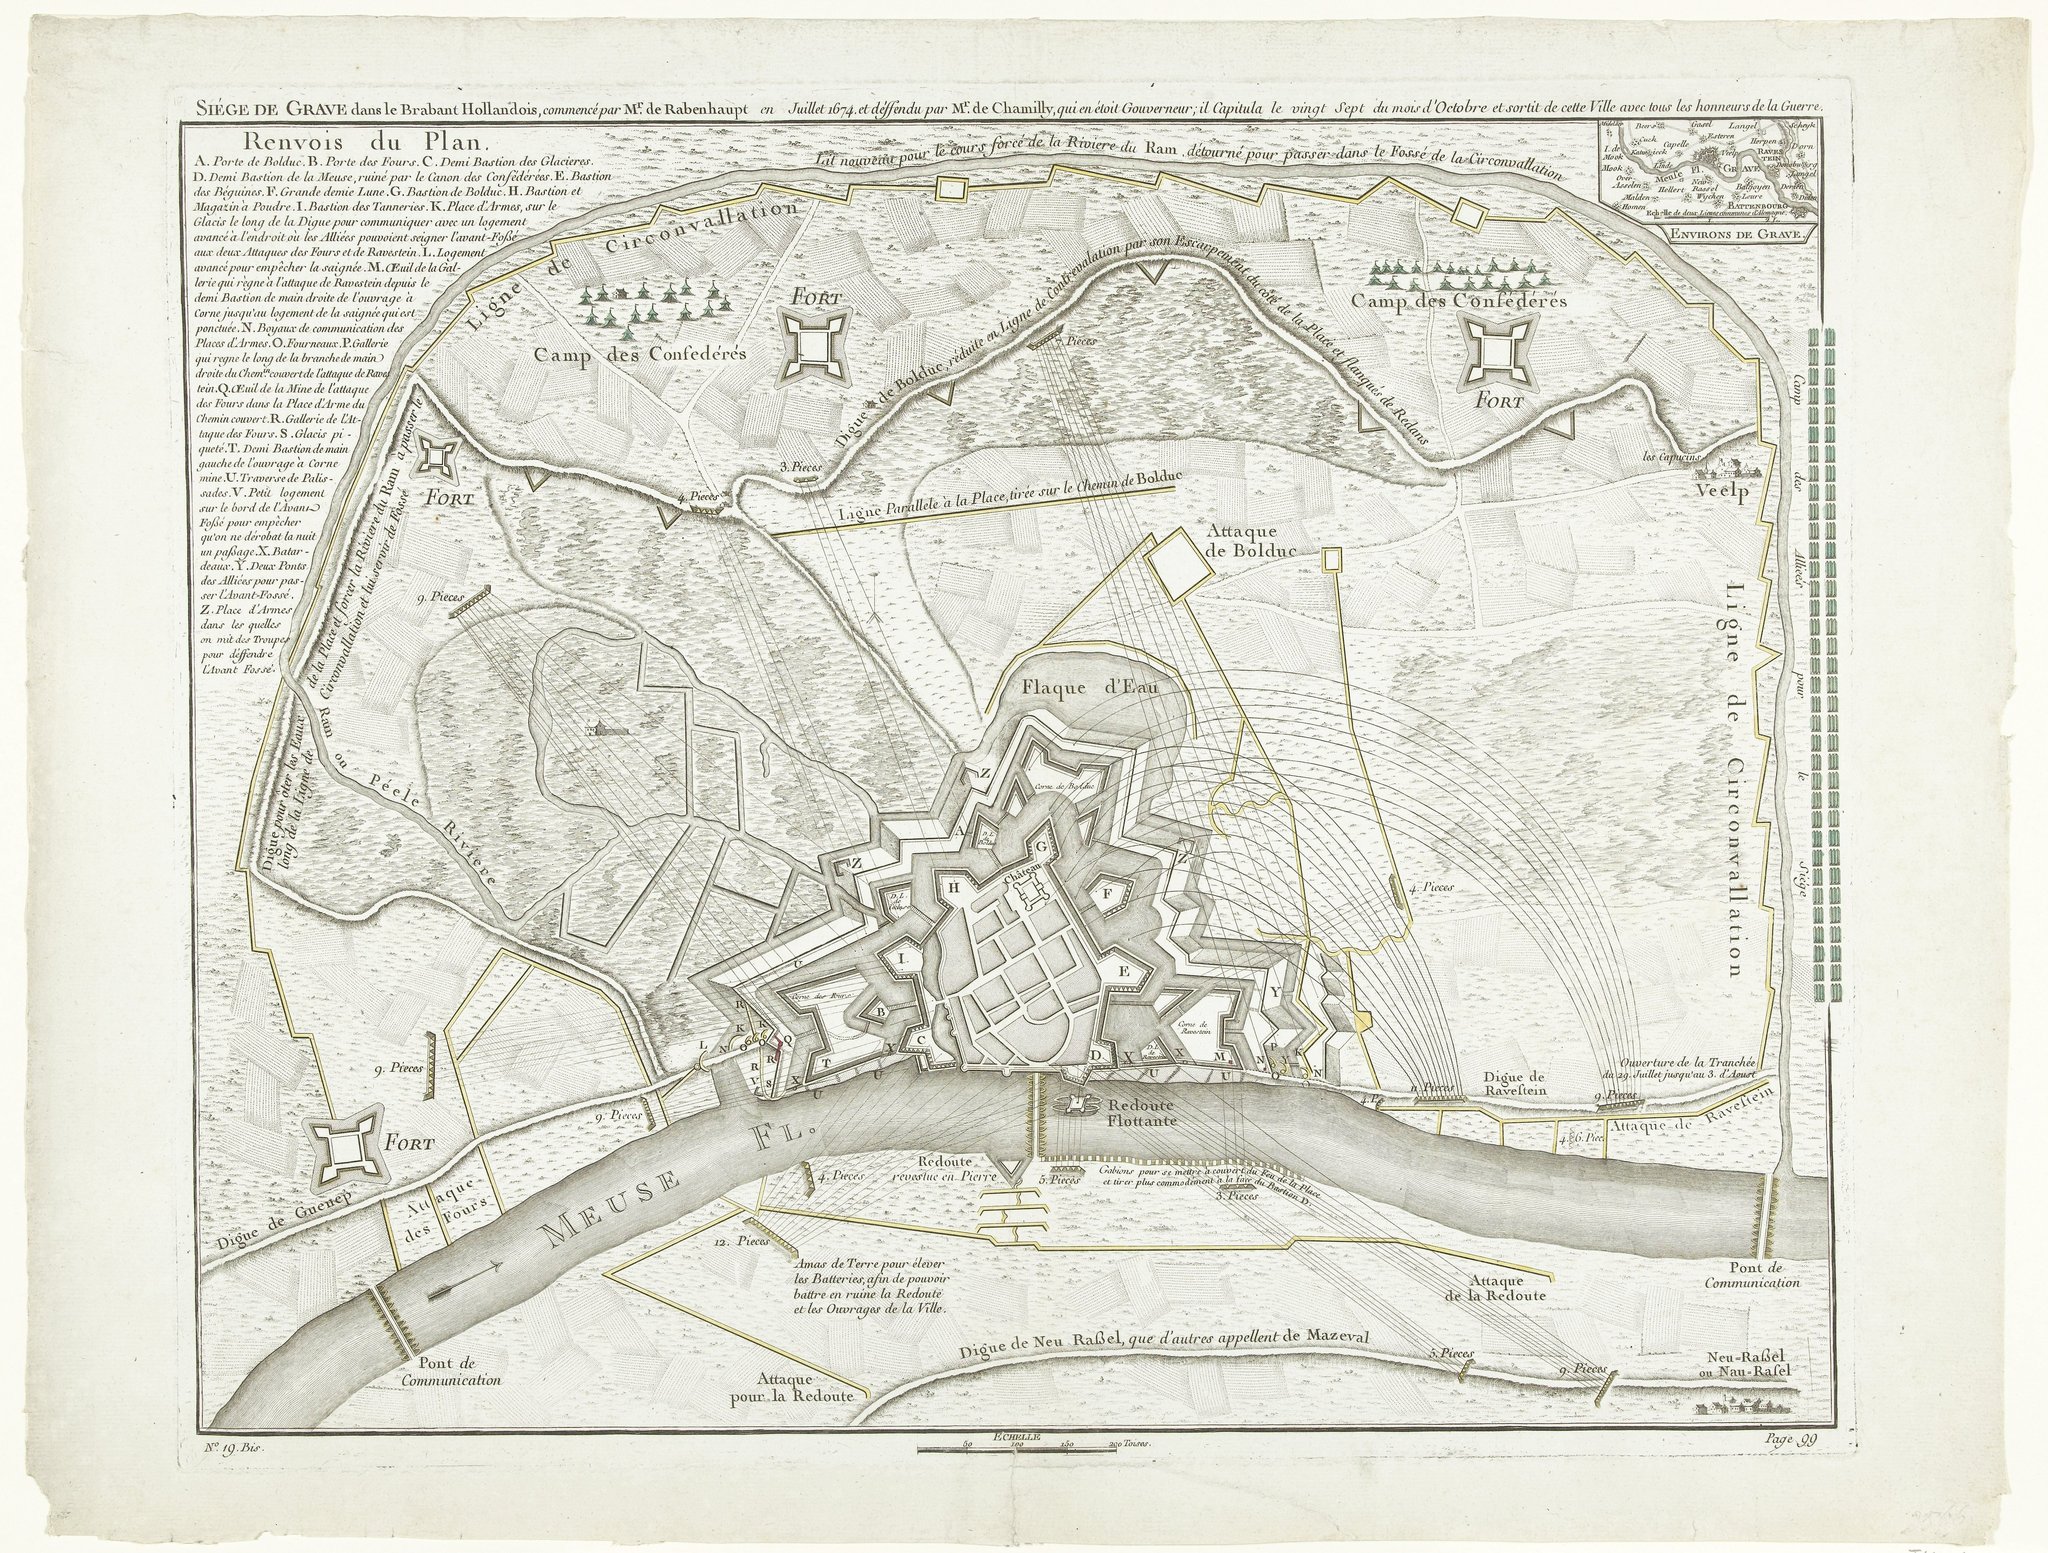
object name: print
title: Kaart van het beleg van Grave door Willem III, 1674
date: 1780-1782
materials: paper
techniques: engraving, etching, hand coloring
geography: france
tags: william iii (prince of orange and king of england, scotland, and ireland), siege, position war, maps of cities, grave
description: Waarschijnlijk gebruikt als illustratie in: Philippe Henri, comte de Grimoard en Chevalier de Beaurain, Histoire des quatre dernieres campagnes du Marechal de Turenne, en 1672, 1673, 1674 & 1675..., Chevalier de Beaurain, Parijs 1782.